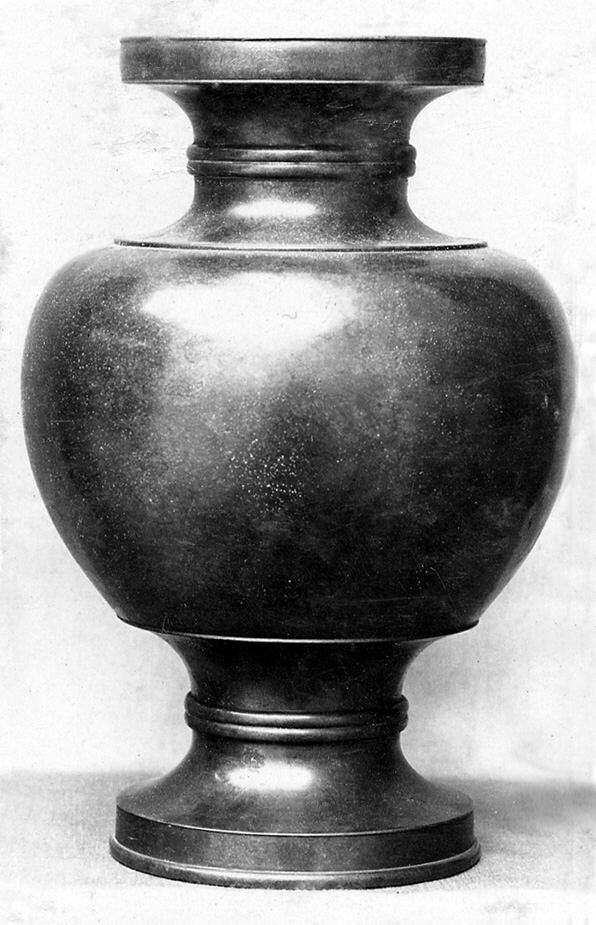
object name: vase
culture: japanese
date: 1801-1900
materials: bronze